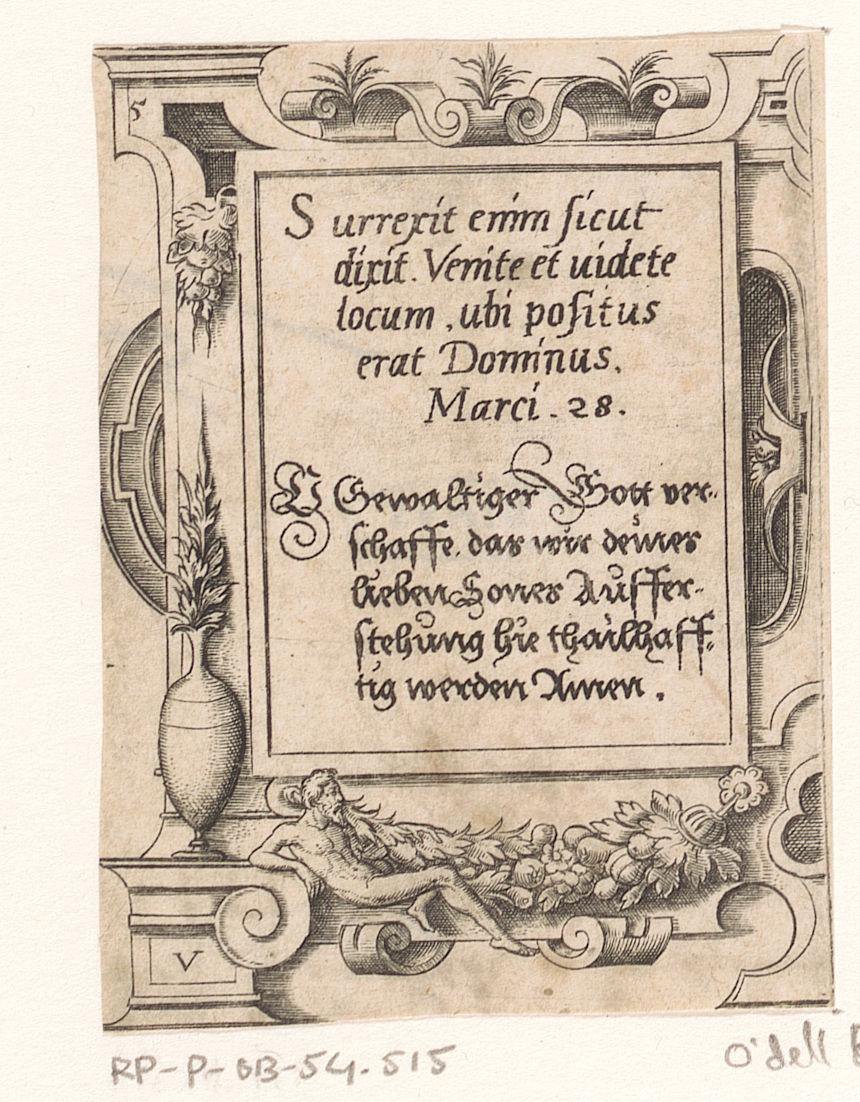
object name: print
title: Gebed in Latijn en Duits in een rolwerk omlijsting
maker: virgilius solis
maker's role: draughtsman, print maker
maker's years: 1514-1562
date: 1568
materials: paper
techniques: engraving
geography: nuremberg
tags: scrollwork, strapwork ~ ornament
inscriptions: number: ‘86’, collector's mark: Lugt 240, collector's mark: Lugt 2228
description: Prent gebruikt voor het gebedenboek: Solis, Virgil. Ein New Künstlich Betbüchlein. Neurenberg: Hieronymus Petri, 1568. Bij elke prent met een Bijbelse scène behoort een genummerde prent met een gebed in het Latijn en in het Duits. Het monogram VS is steeds verspreid over twee bij elkaar horende prenten.